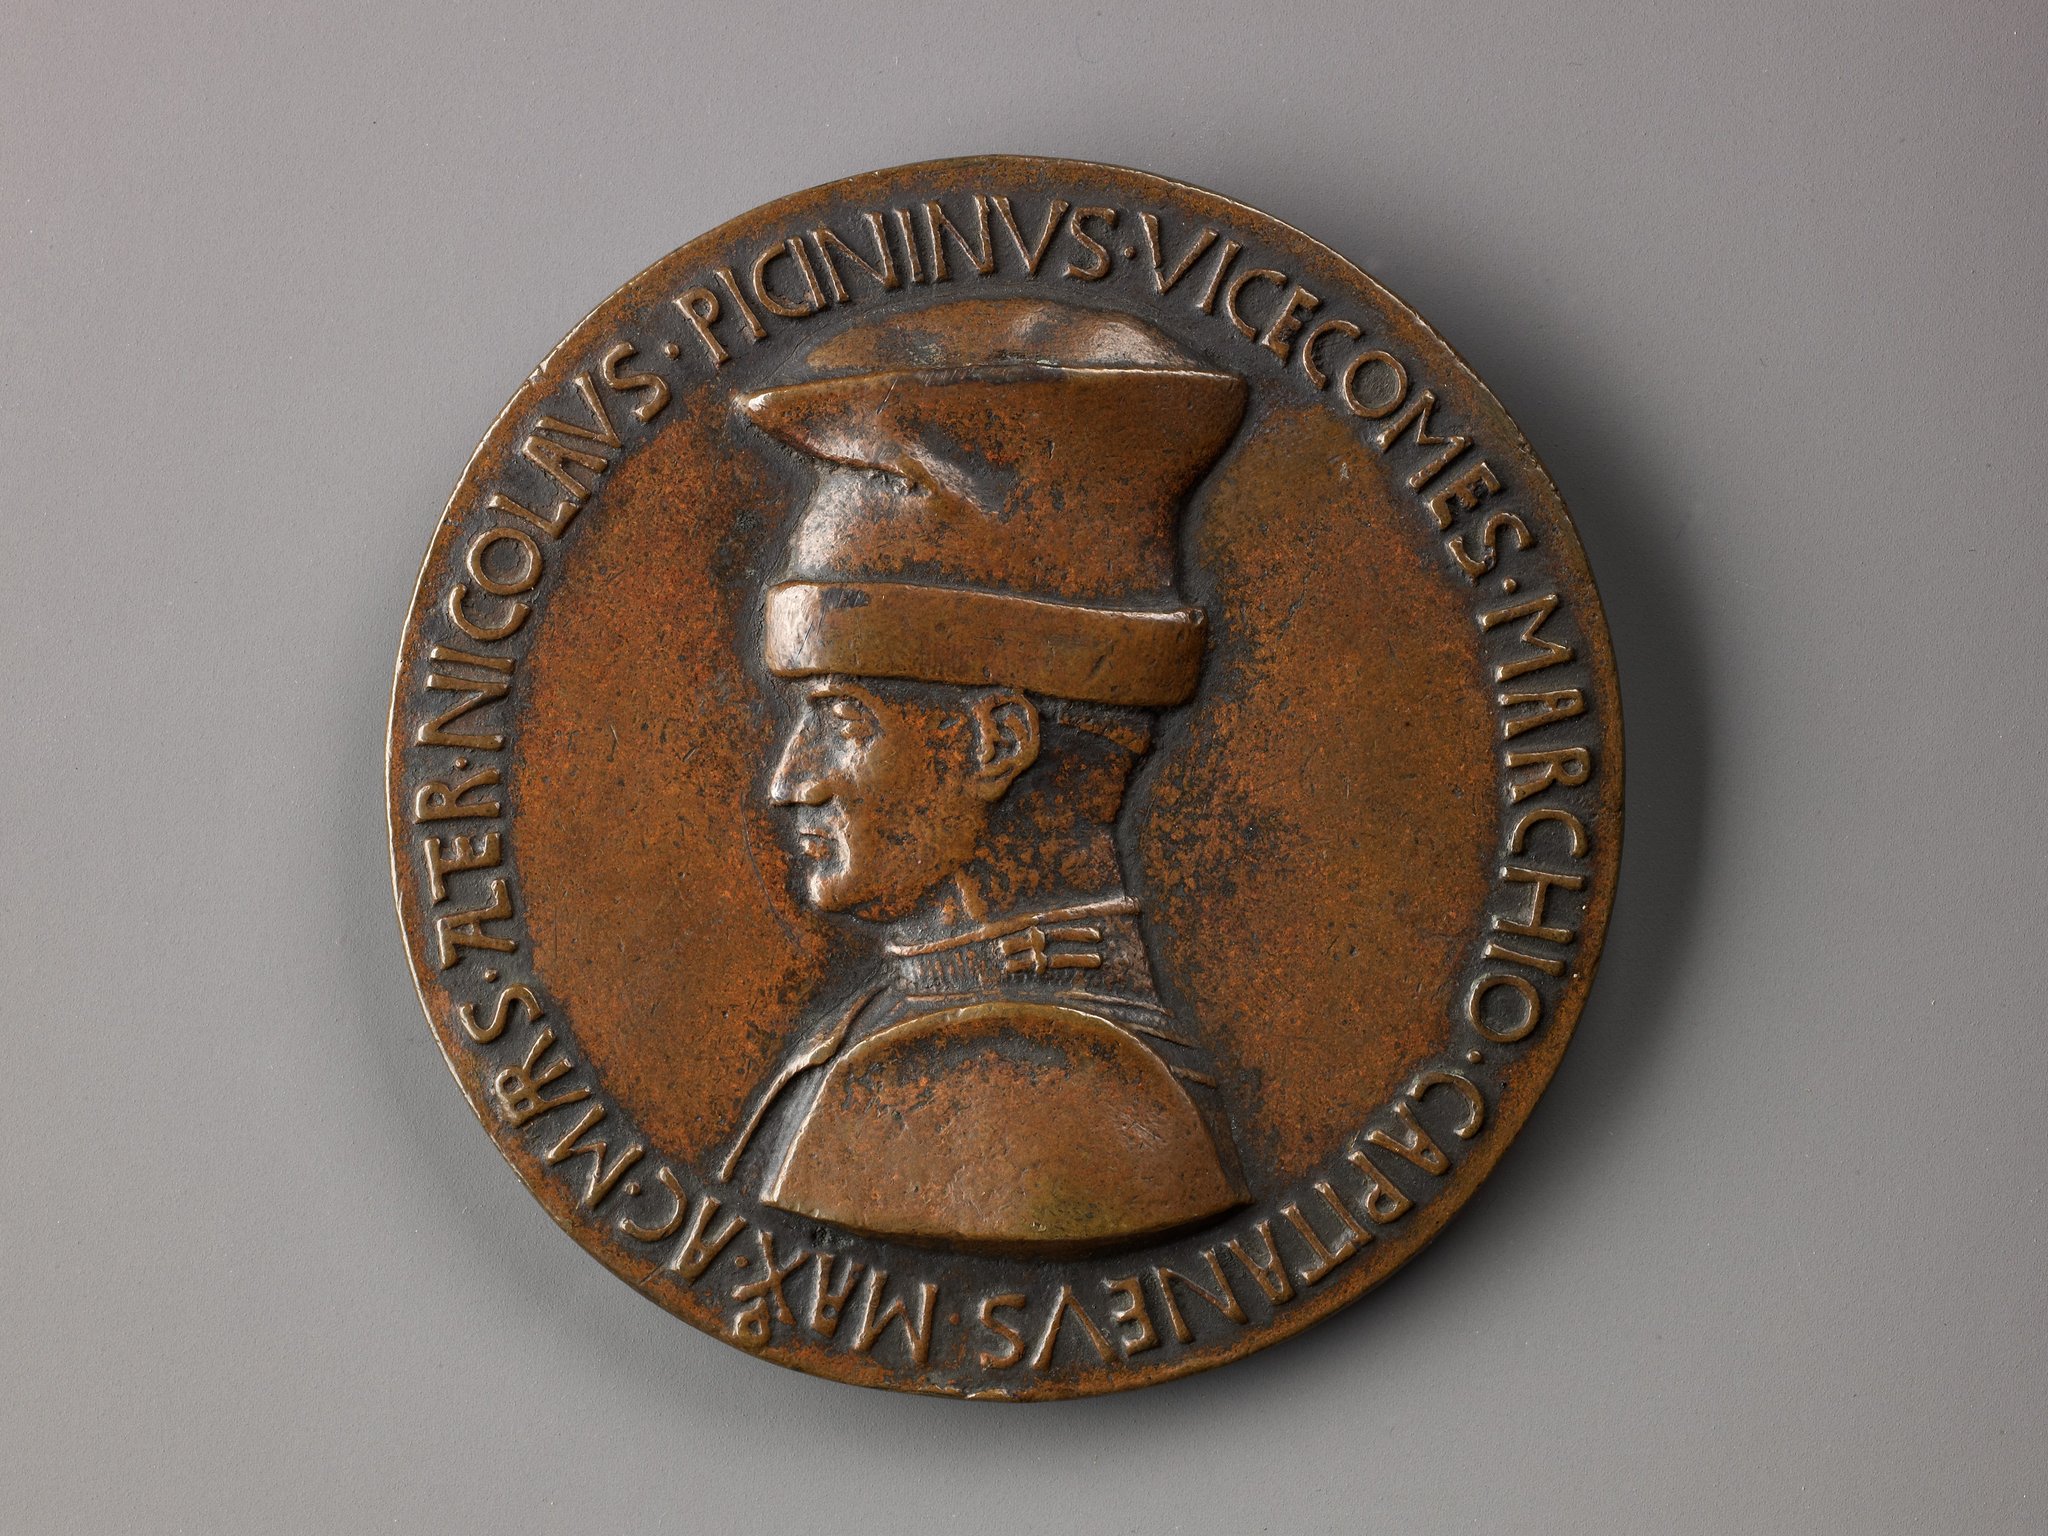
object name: medal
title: Portrait medal of Niccolò Piccinino (obverse); A Griffin (reverse)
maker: pisanello (antonio pisano)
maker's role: artist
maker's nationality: italian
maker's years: 1395-1455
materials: bronze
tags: men,portraits,profiles,griffins